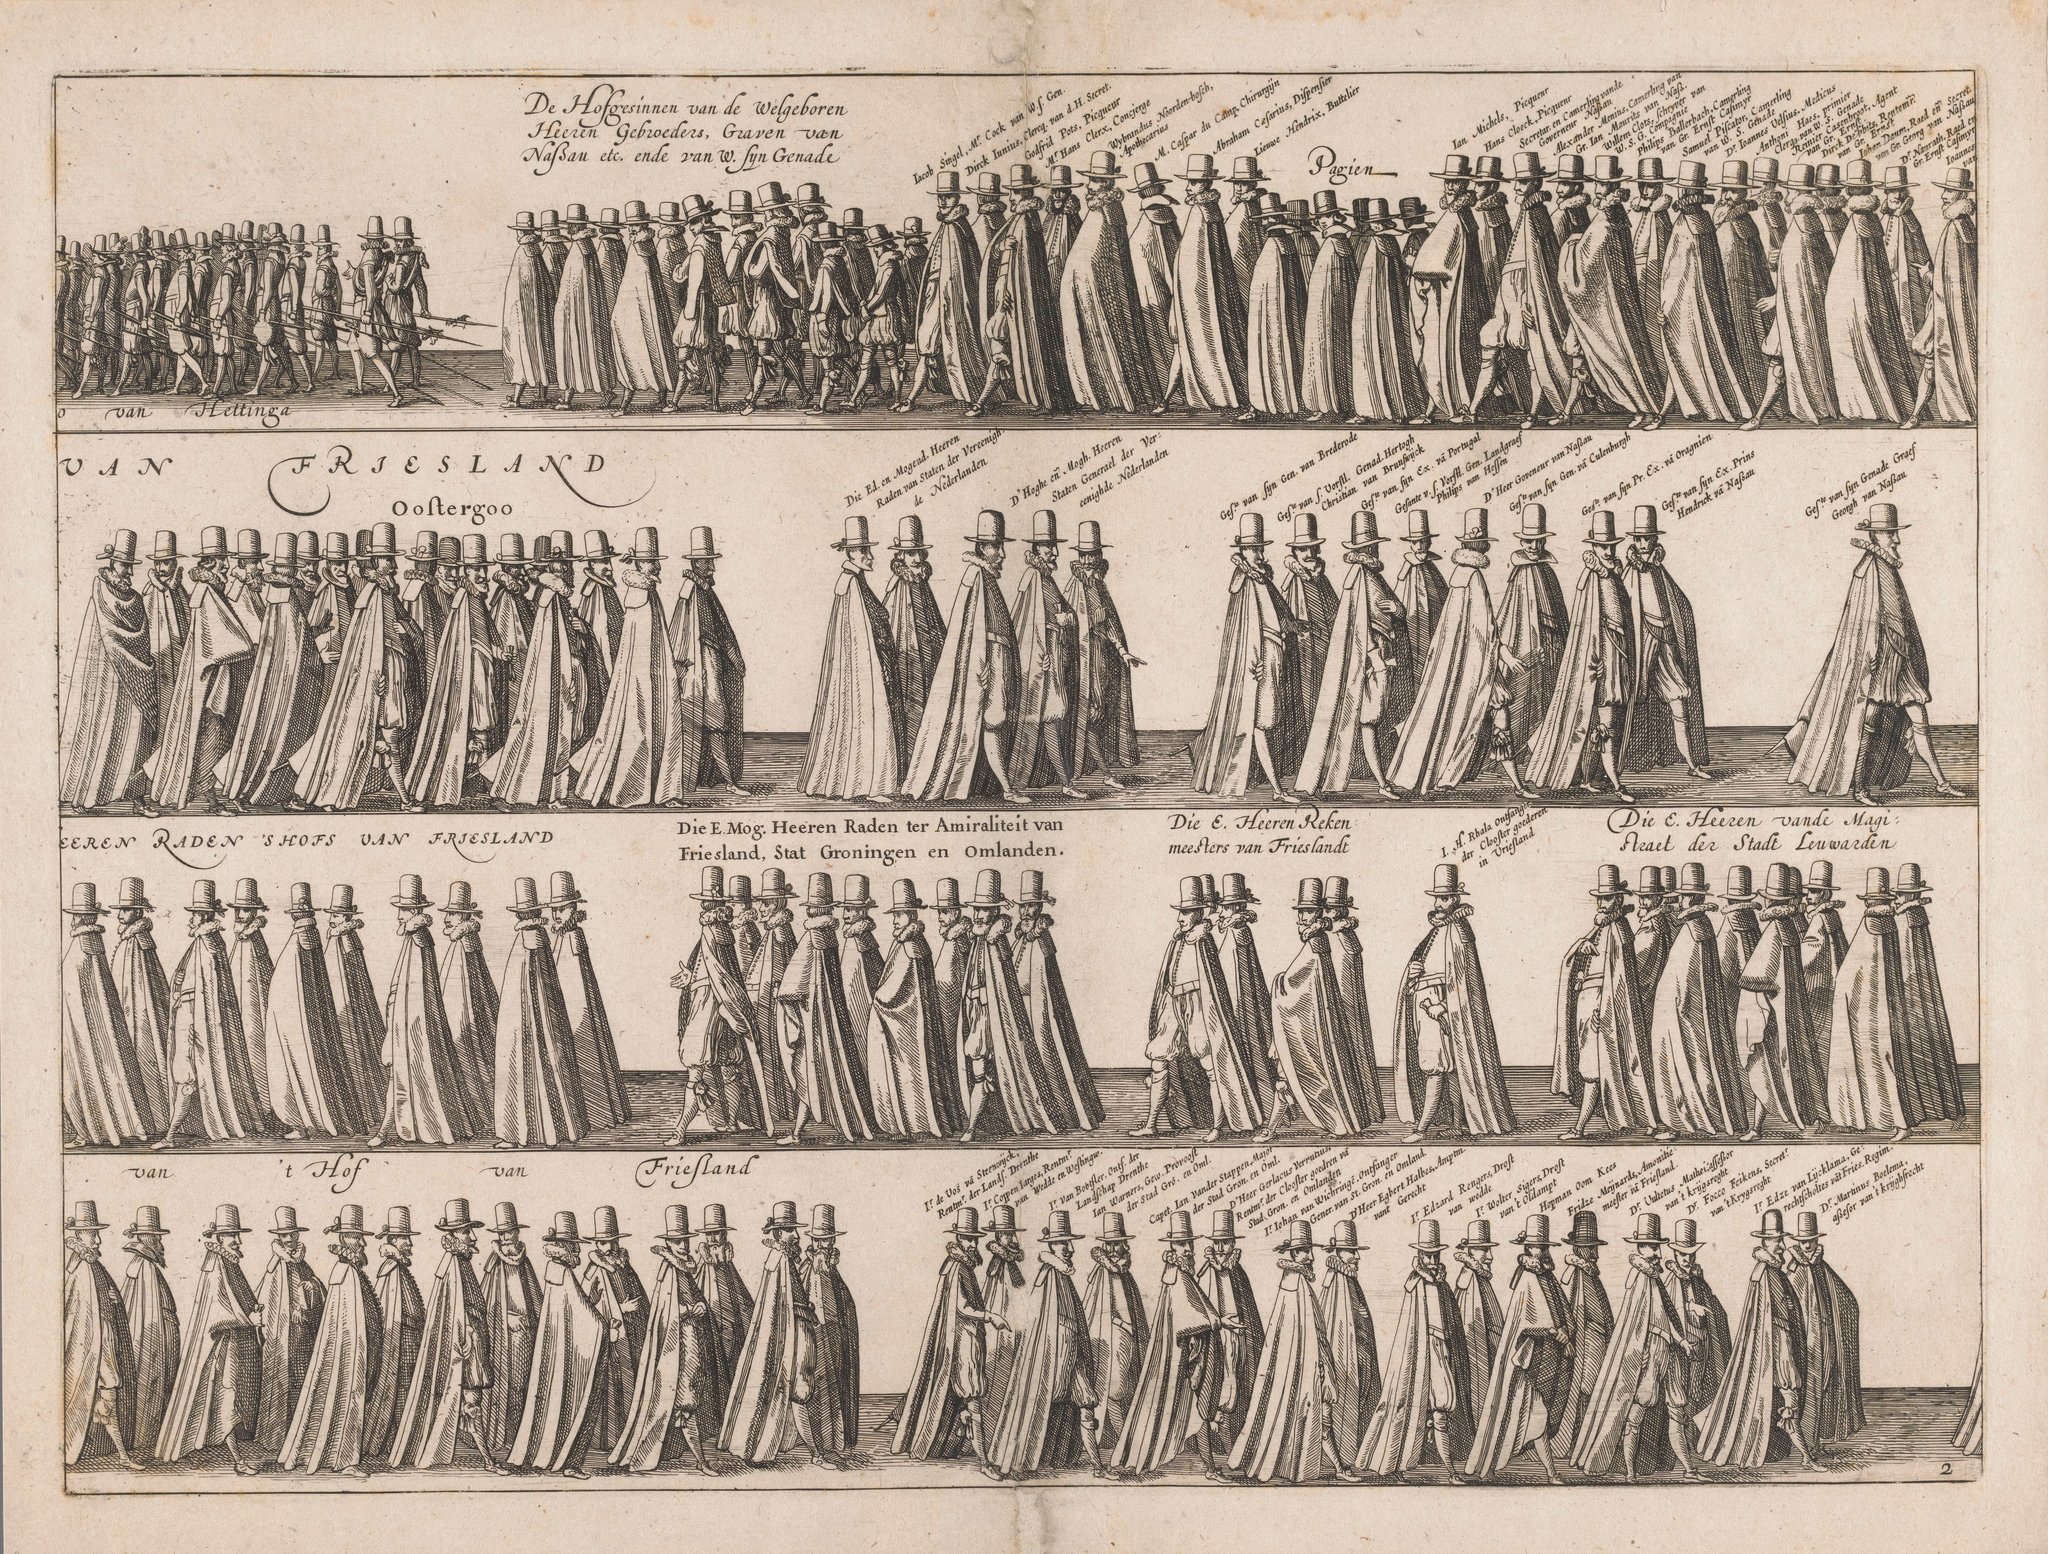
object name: print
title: Begrafenis van Willem Lodewijk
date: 1620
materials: paper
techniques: etching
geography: friesland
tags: begrafenisoptocht van willem lodewijk van nassau-dillenburg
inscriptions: collector's mark: Lugt 2228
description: Begrafenisstoet na het overlijden van Willem Lodewijk van Nassau-Dillenburg, stadhouder van Friesland. Een stoet hoogwaardigheidsbekleders, in vier rijen boven elkaar. Plaat nummer twee van de in totaal vier platen.